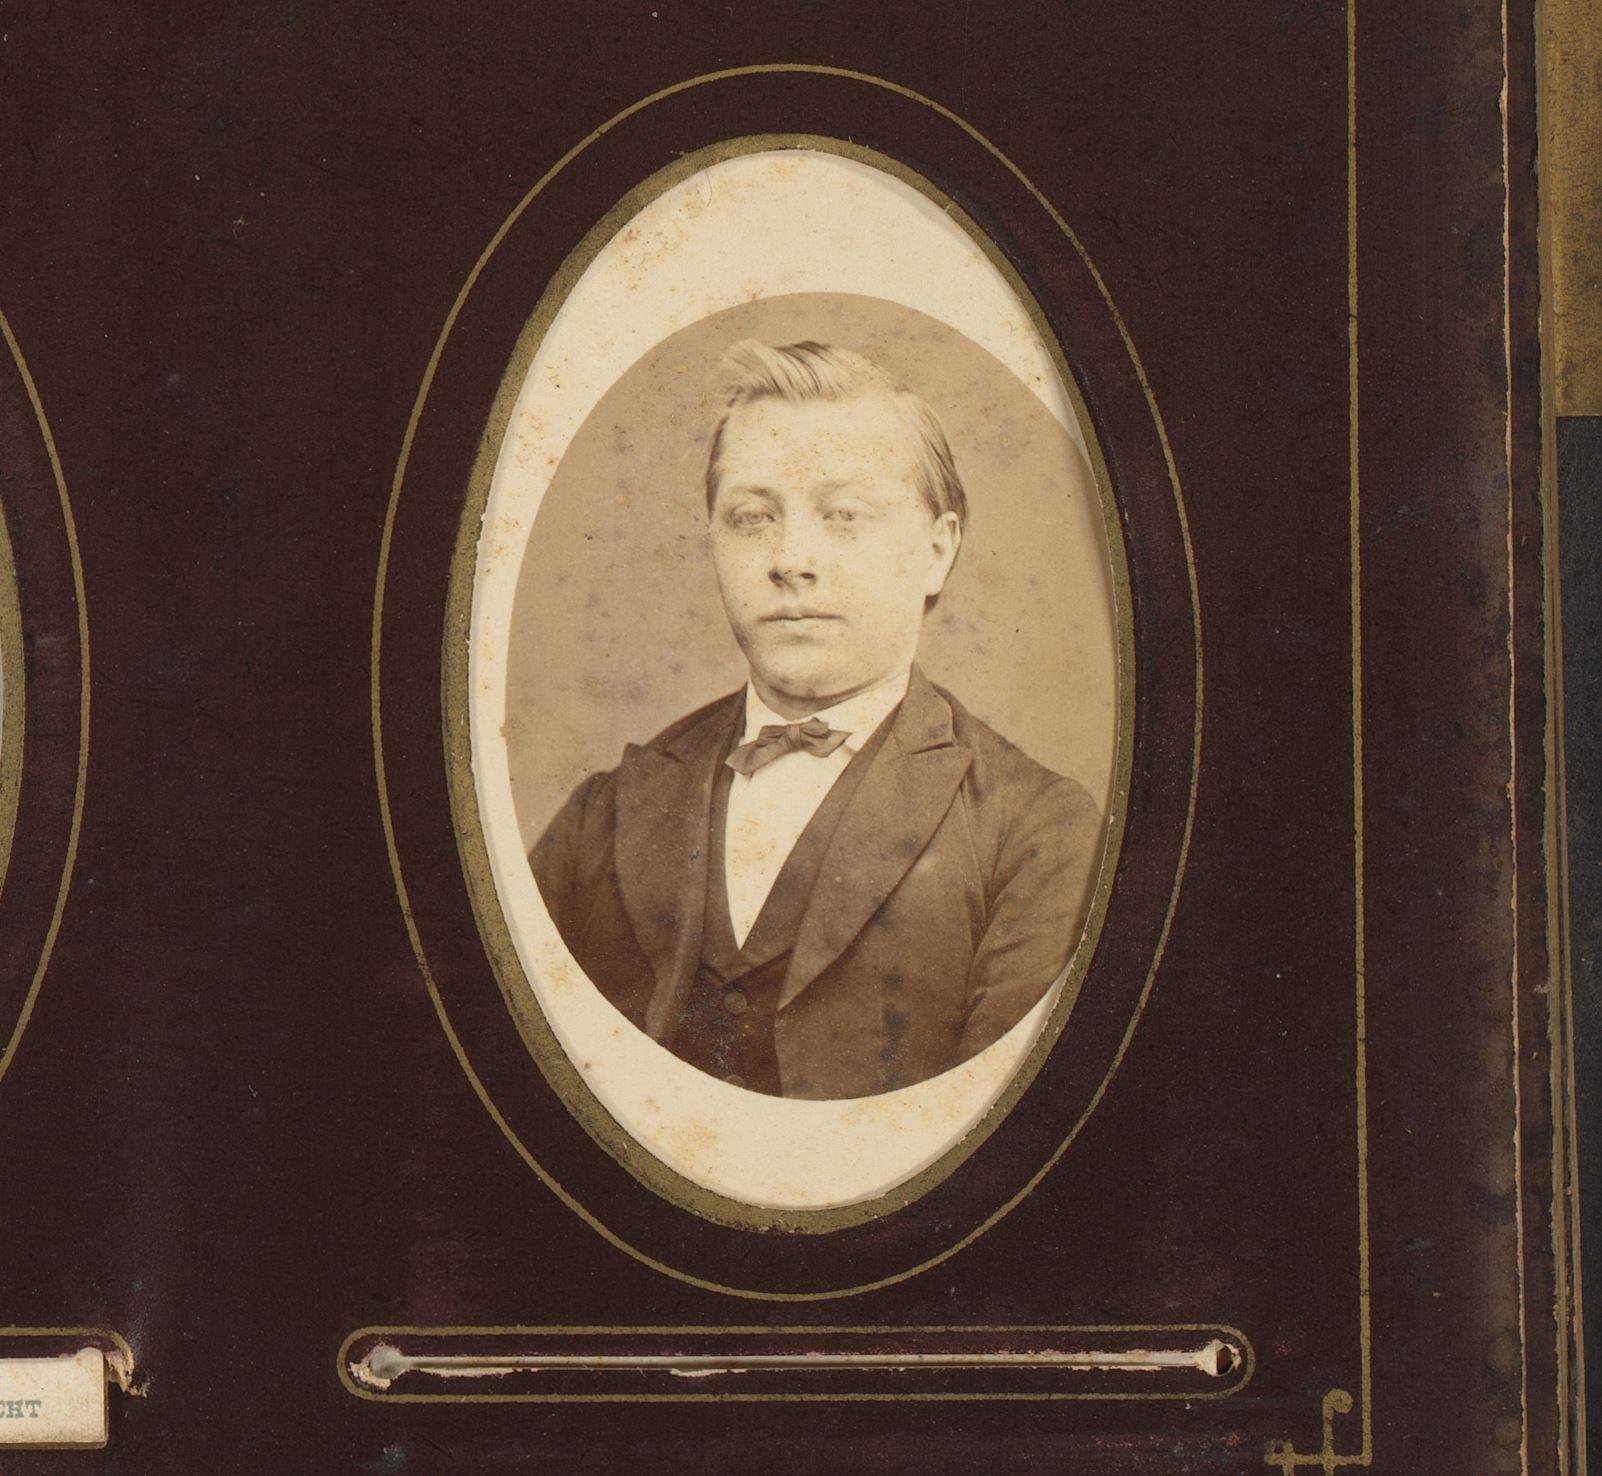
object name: photograph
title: Portret van een jonge man met vlinderstrik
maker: pieter vlaanderen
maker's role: fotograaf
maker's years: 1840-1878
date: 1867-1878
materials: cardboard, photographic support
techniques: albumen print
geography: alkmaar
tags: historical persons, youth, adolescent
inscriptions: inscription: ‘P.V./ ATELIER DE REMBRANDT/ van/ P. VLAANDEREN/ Verdronken Oord/ Wyk D. No. 34./ ALKMAAR’